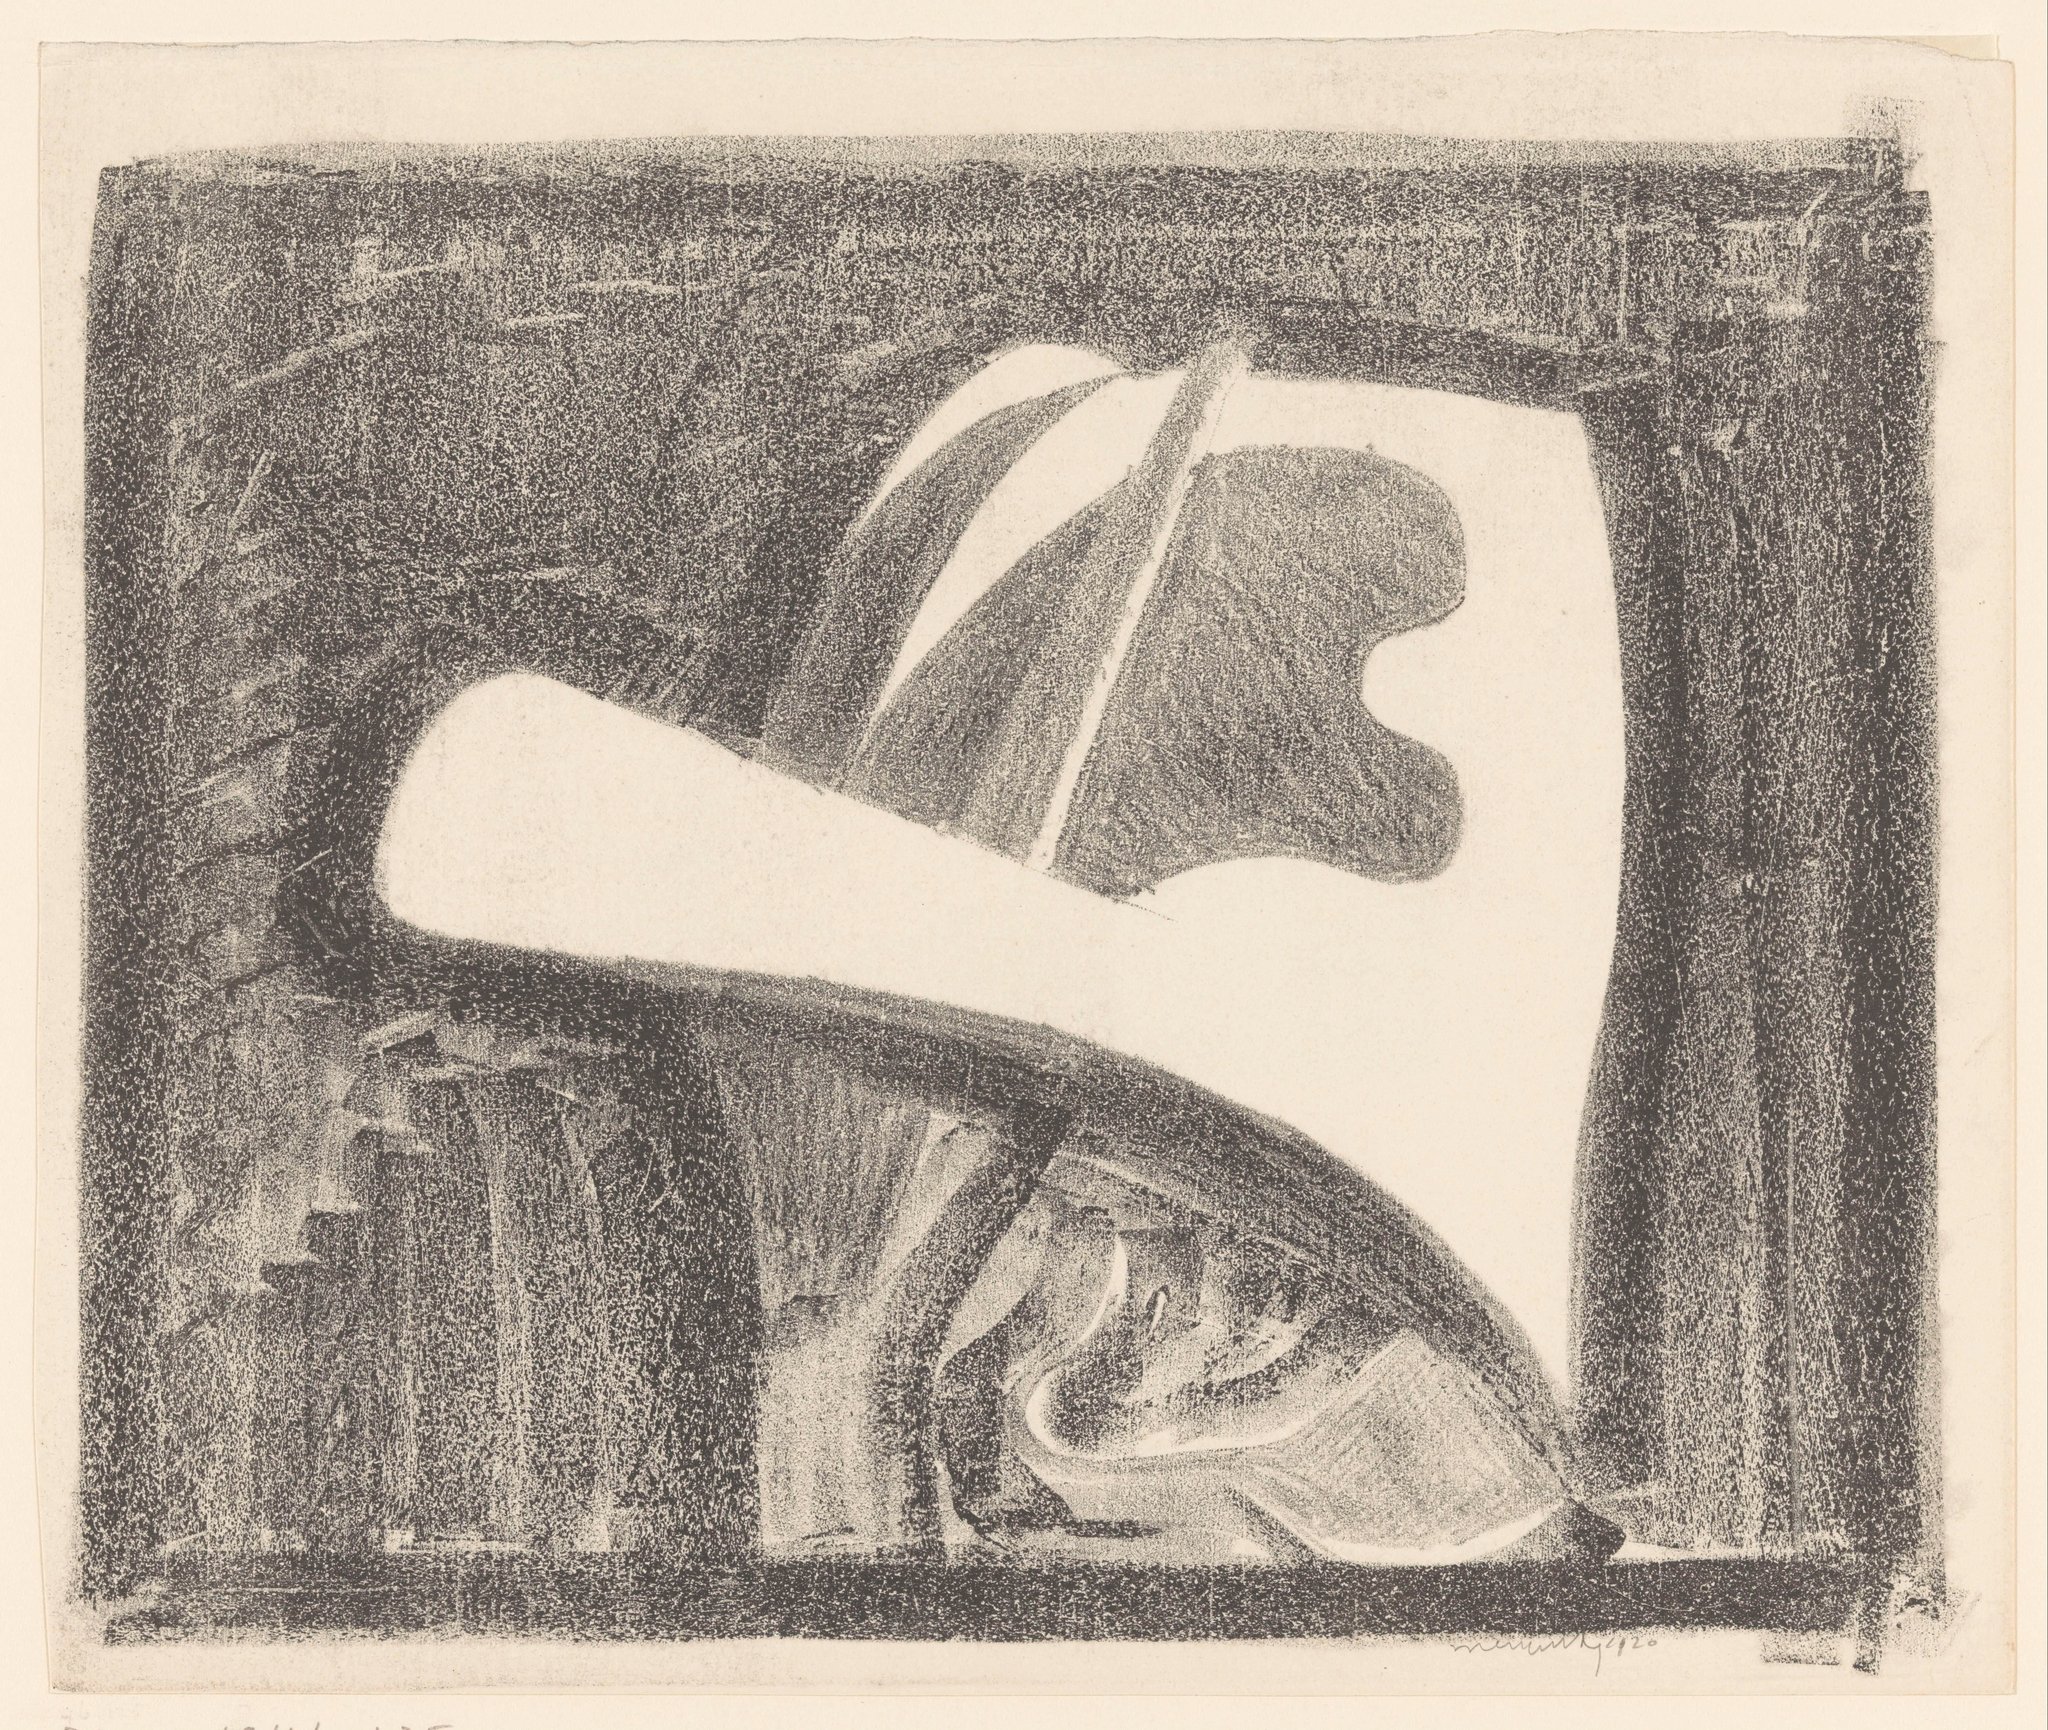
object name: print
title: Aronskelk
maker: samuel jessurun de mesquita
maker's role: draughtsman, print maker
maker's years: 1868-1944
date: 1920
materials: paper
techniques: lithograph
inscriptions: signature and date: ‘mesquita 1920’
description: Abstract aandoende voorstelling met langwerpige witte vorm tegen grijze achtergrond.